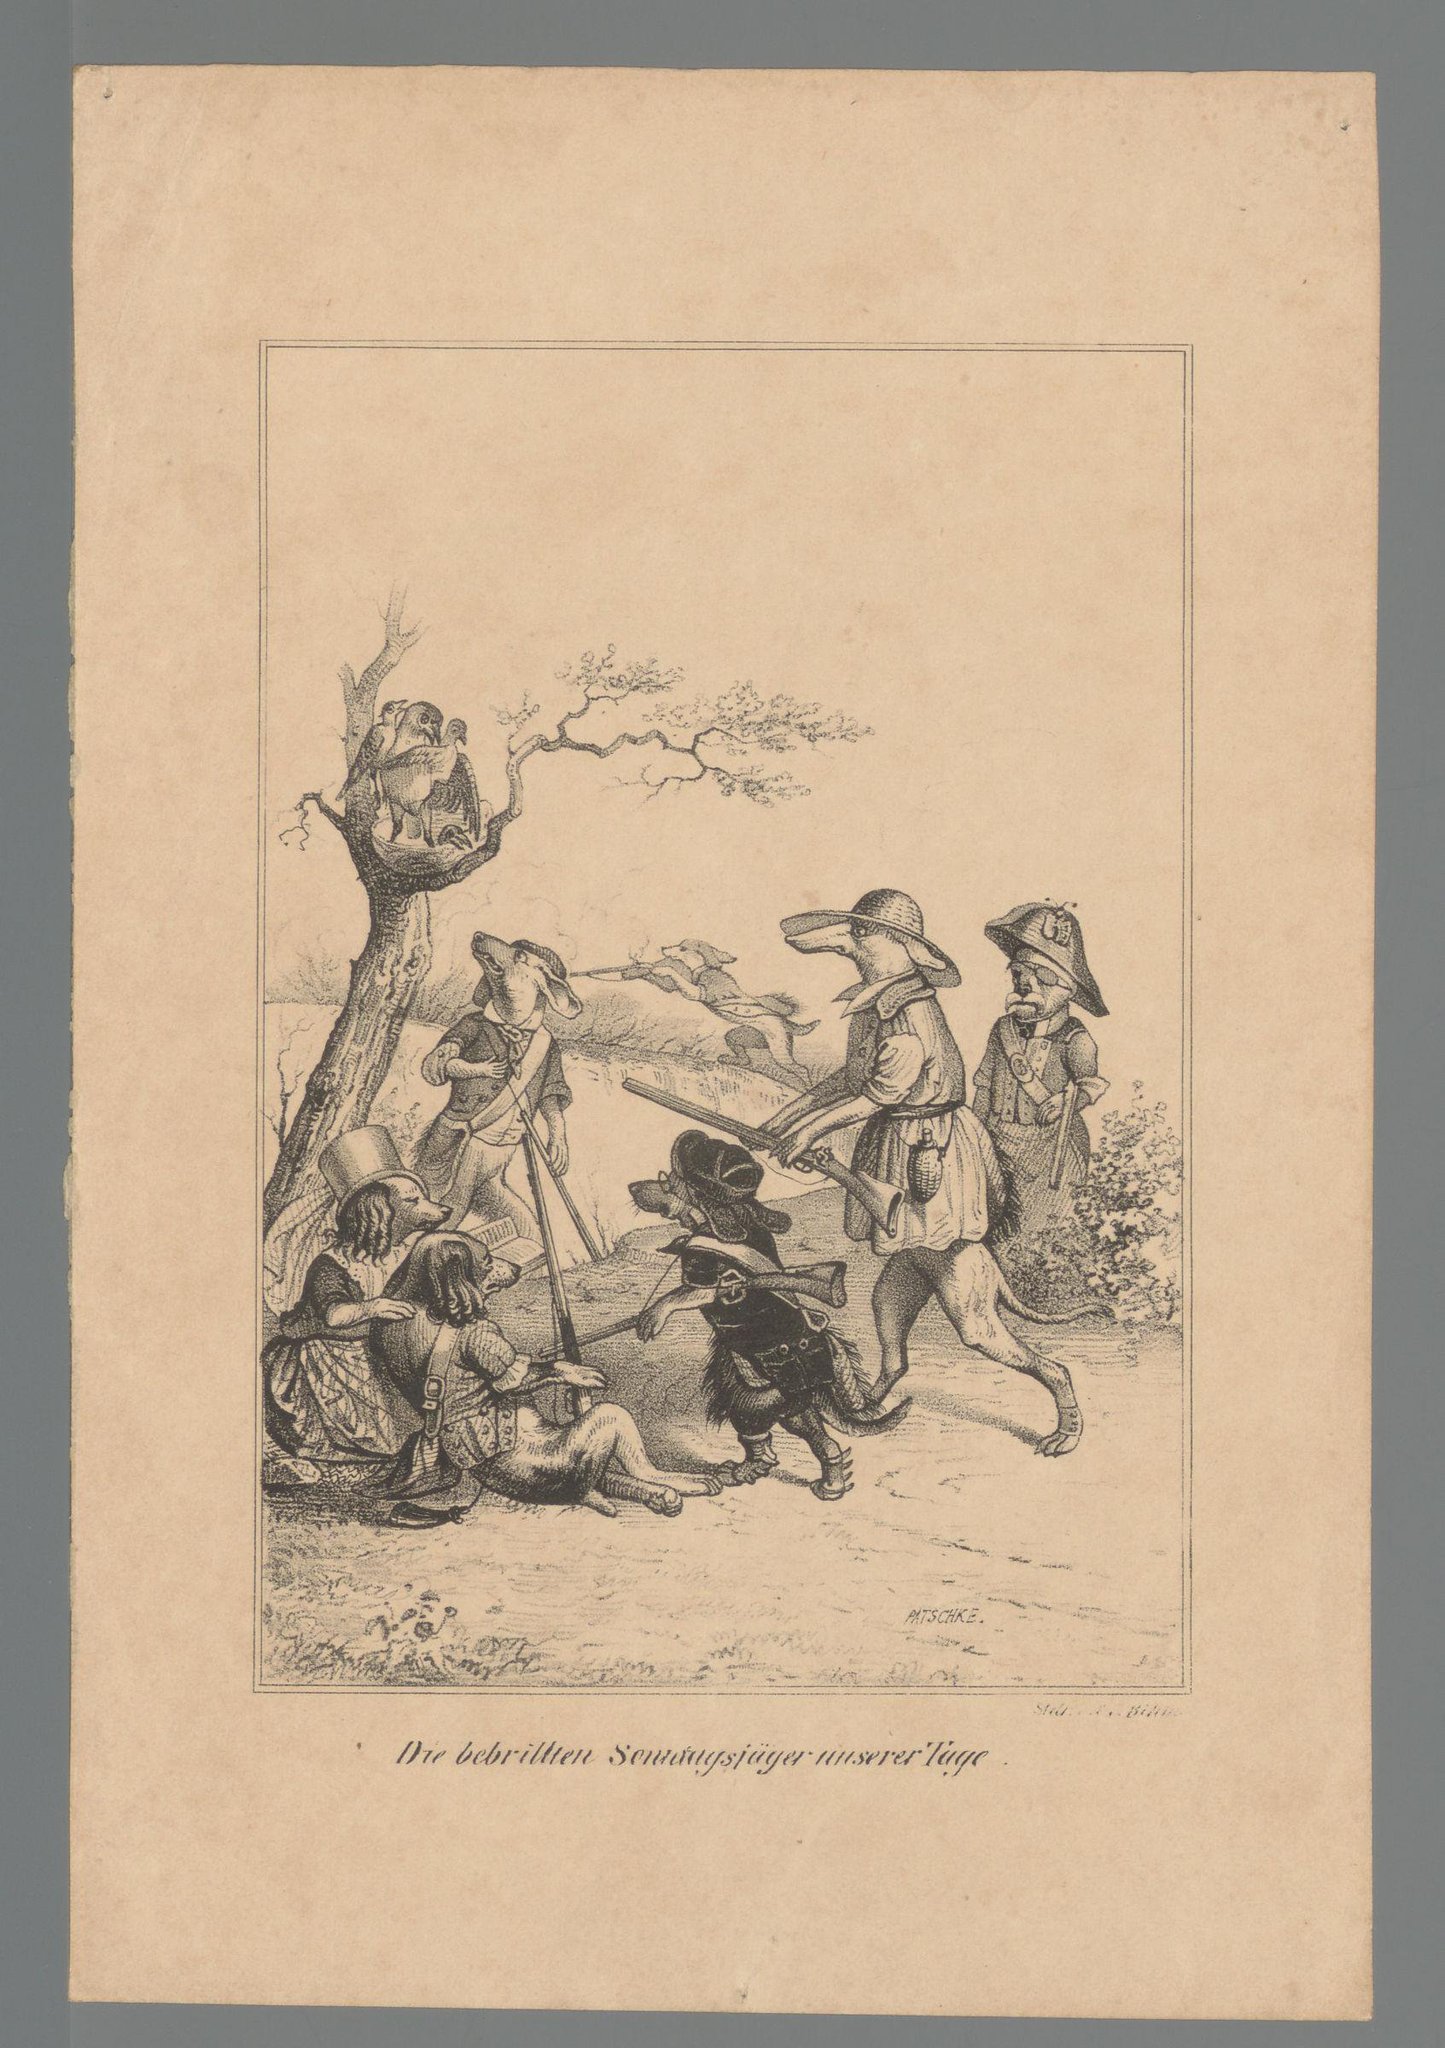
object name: book illustration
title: Die bebrillten Sowangsjäger unserer Tage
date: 1841-1842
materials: paper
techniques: lithograph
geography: leipzig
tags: hunting dogs, animals acting as human beings, firearms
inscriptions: collector's mark: Lugt 2228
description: Prent uit: Gerard, Jean-Ignace-Isidore. Das neunzehnte Jahrhundert des Thierreichs oder Scenen aus dem Familien- und Staatsleben der Thiere. Leipzig: Friedrich Volckmar, [1841-1842].